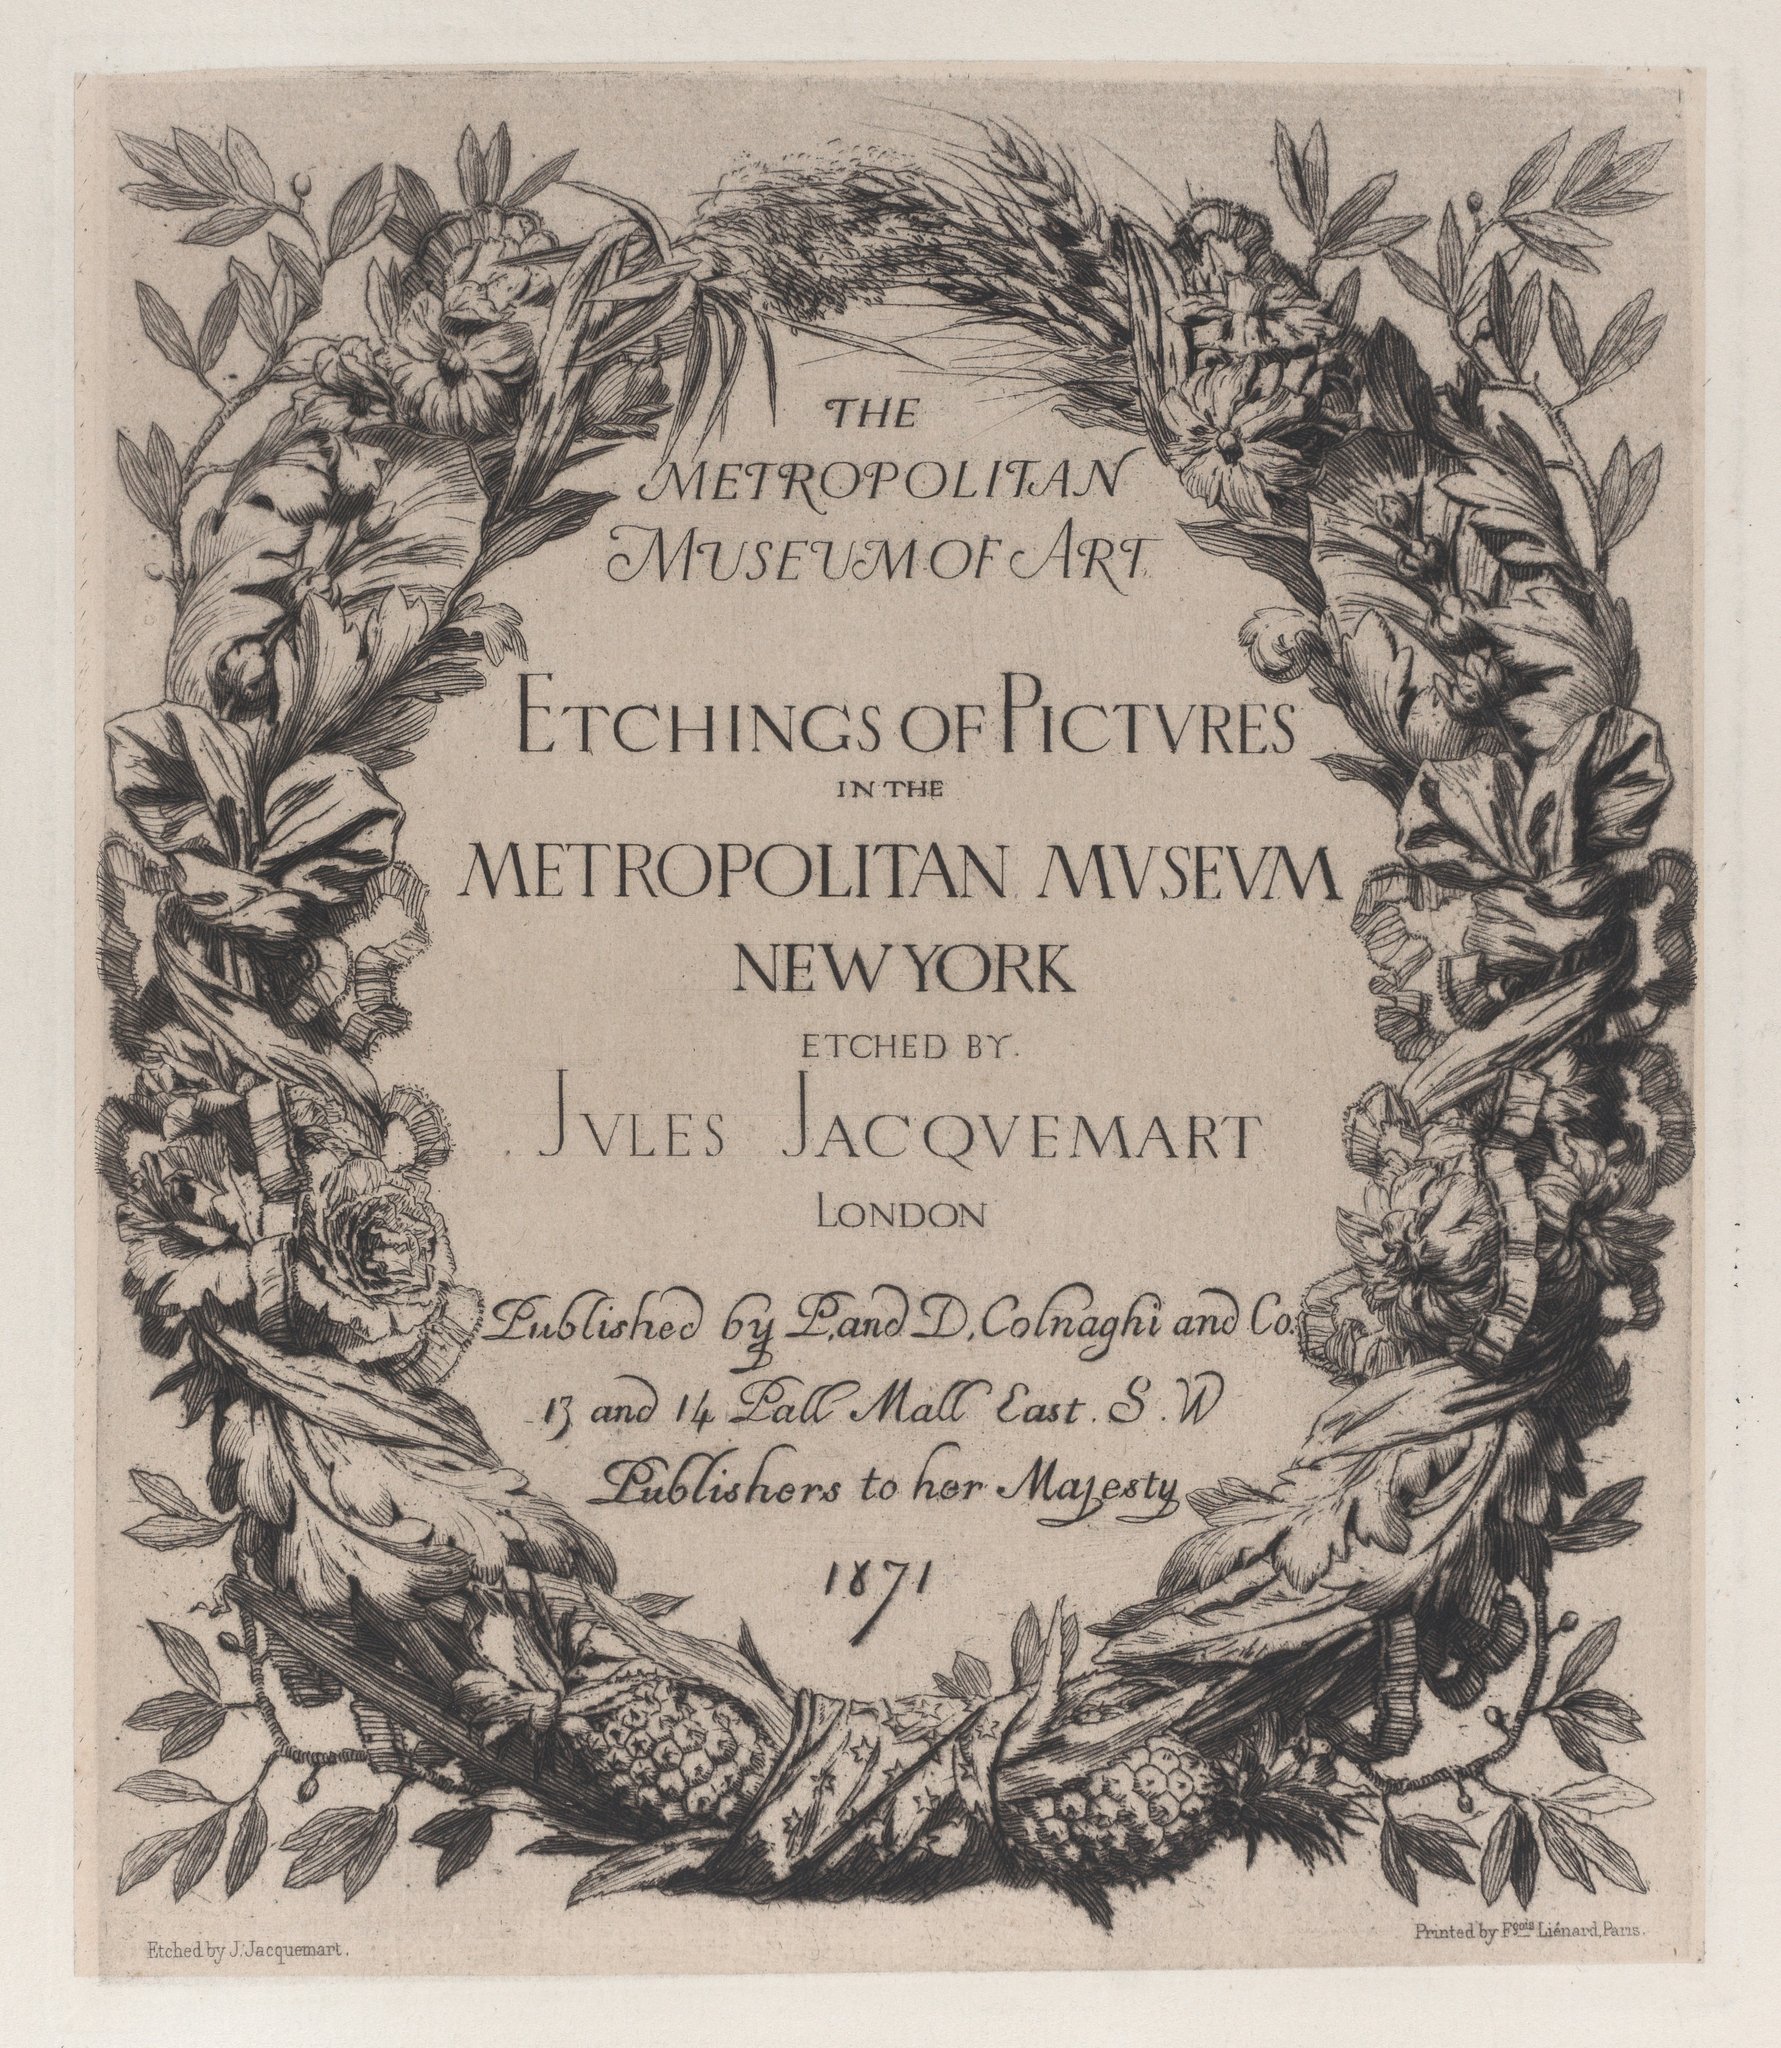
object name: print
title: Title page, from "Etchings of Pictures in the Metropolitan Museum New York"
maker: jules-ferdinand jacquemart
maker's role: artist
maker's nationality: french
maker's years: 1837-1880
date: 1871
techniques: printmaking, etching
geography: paris